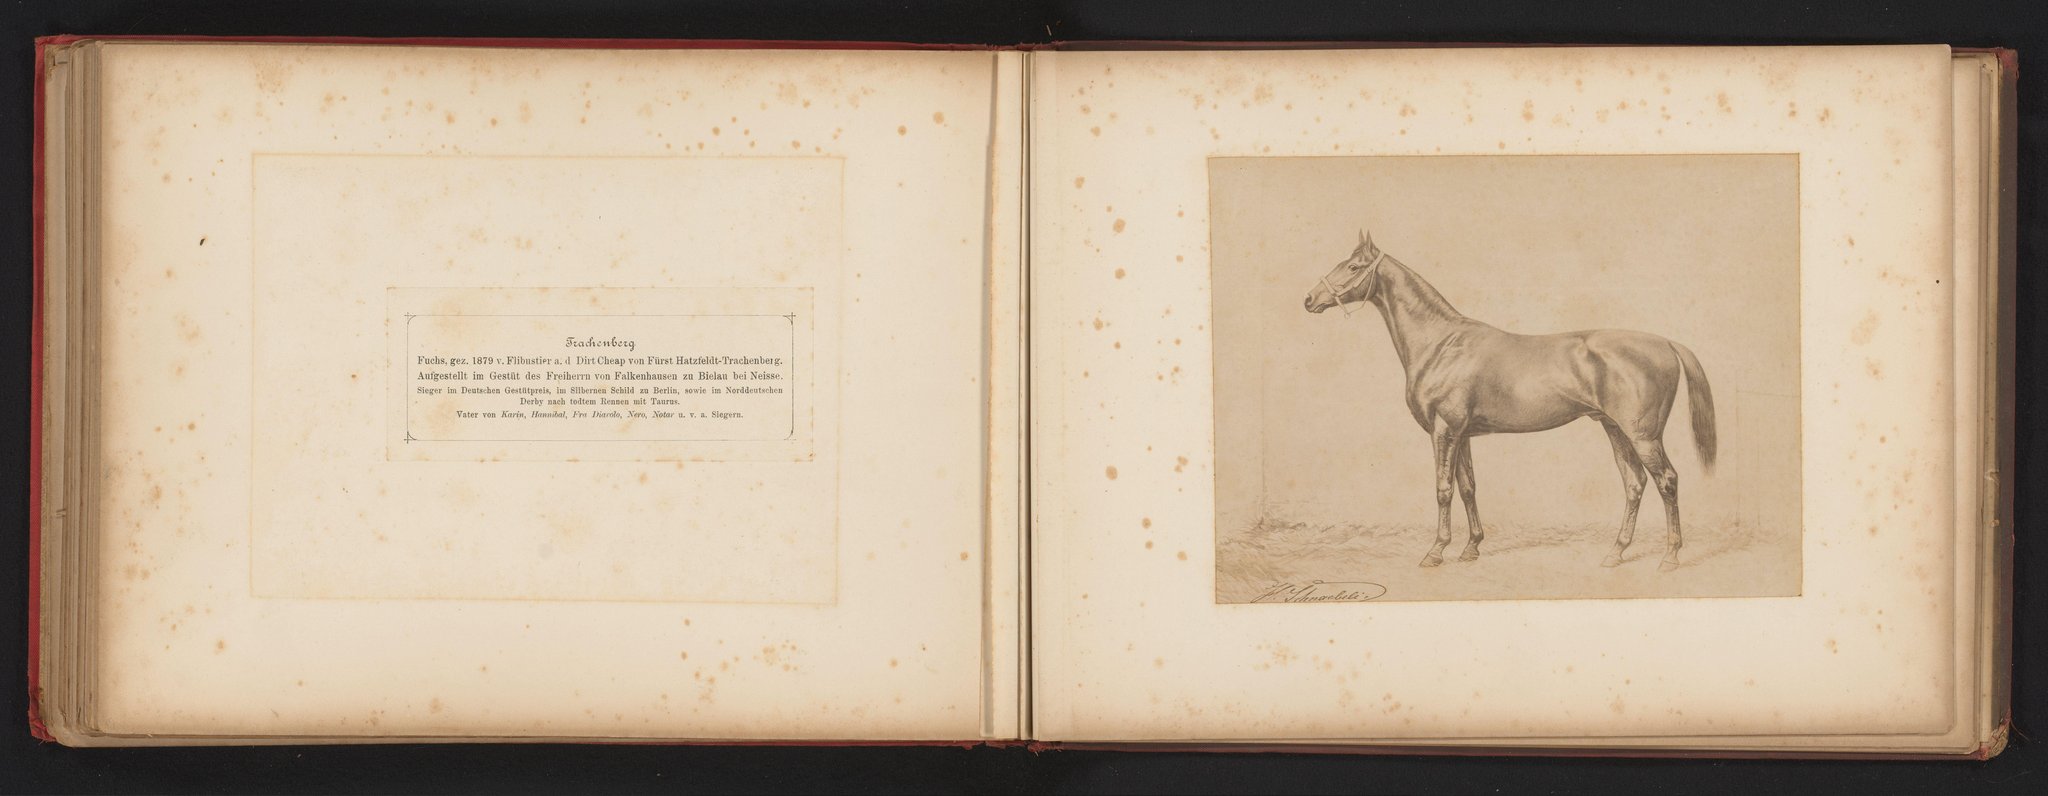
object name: reproduction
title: Fotoreproductie van een tekening van een paard, genaamd Trachenberg, door H. Schnaebeli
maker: h. schnaebeli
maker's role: fotograaf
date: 1894-1915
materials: photographic support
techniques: albumen print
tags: horse